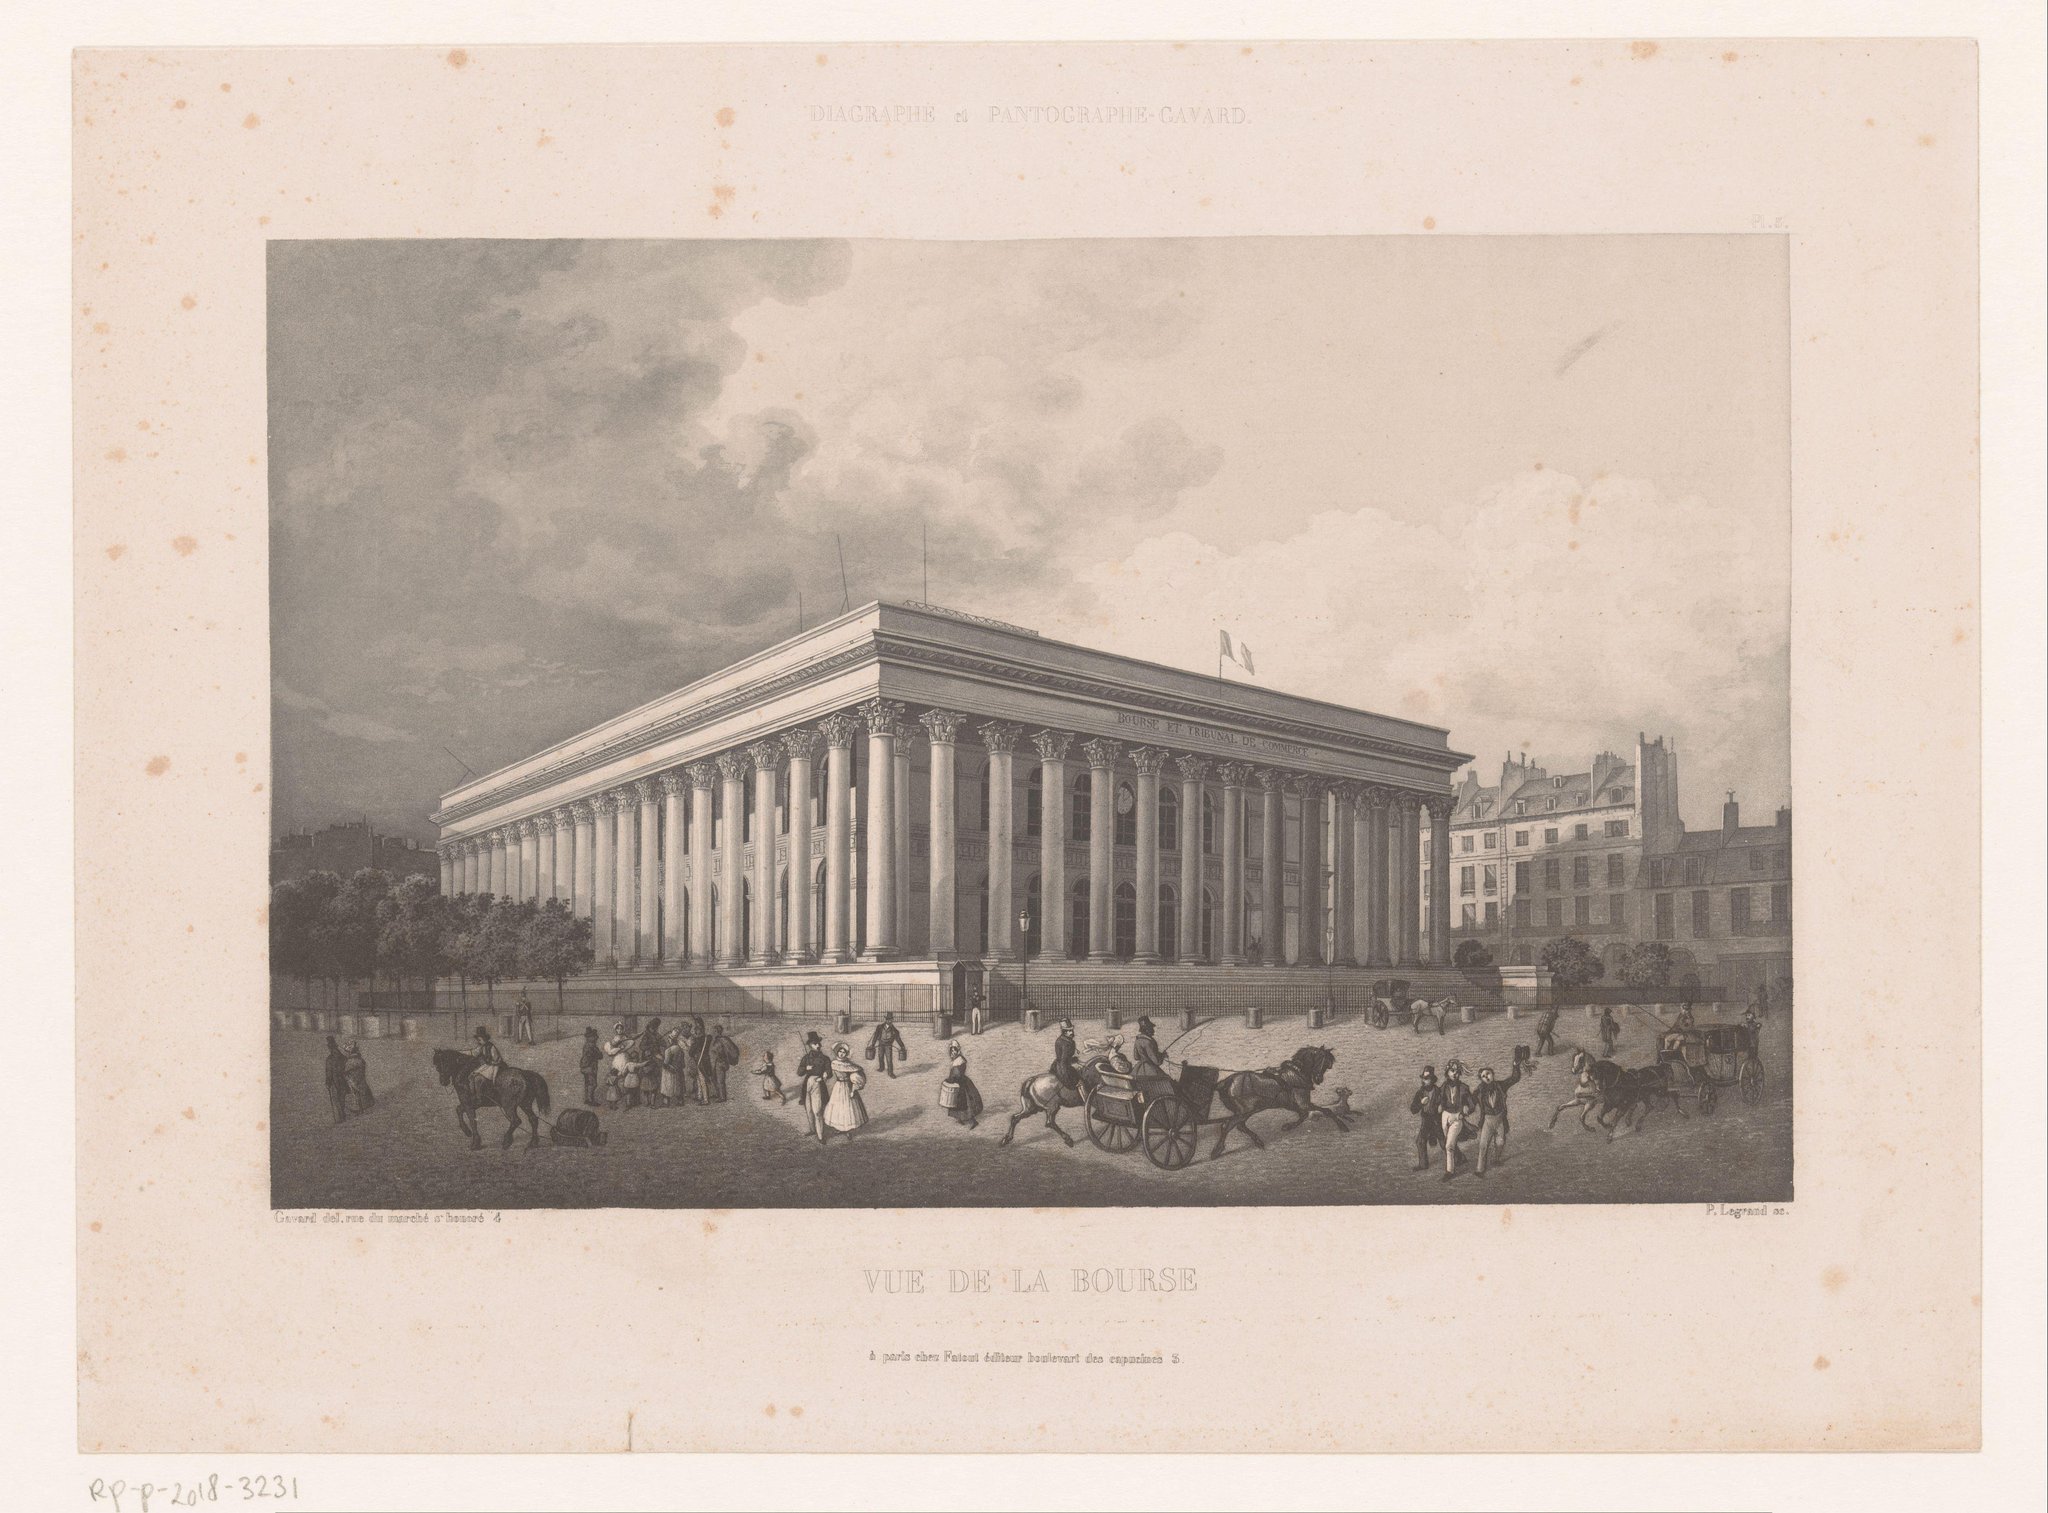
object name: print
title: Gezicht op het beursgebouw te Parijs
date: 1835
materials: paper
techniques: lithograph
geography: paris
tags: stock exchange, stock-market, paris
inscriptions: collector's mark: Lugt 2228